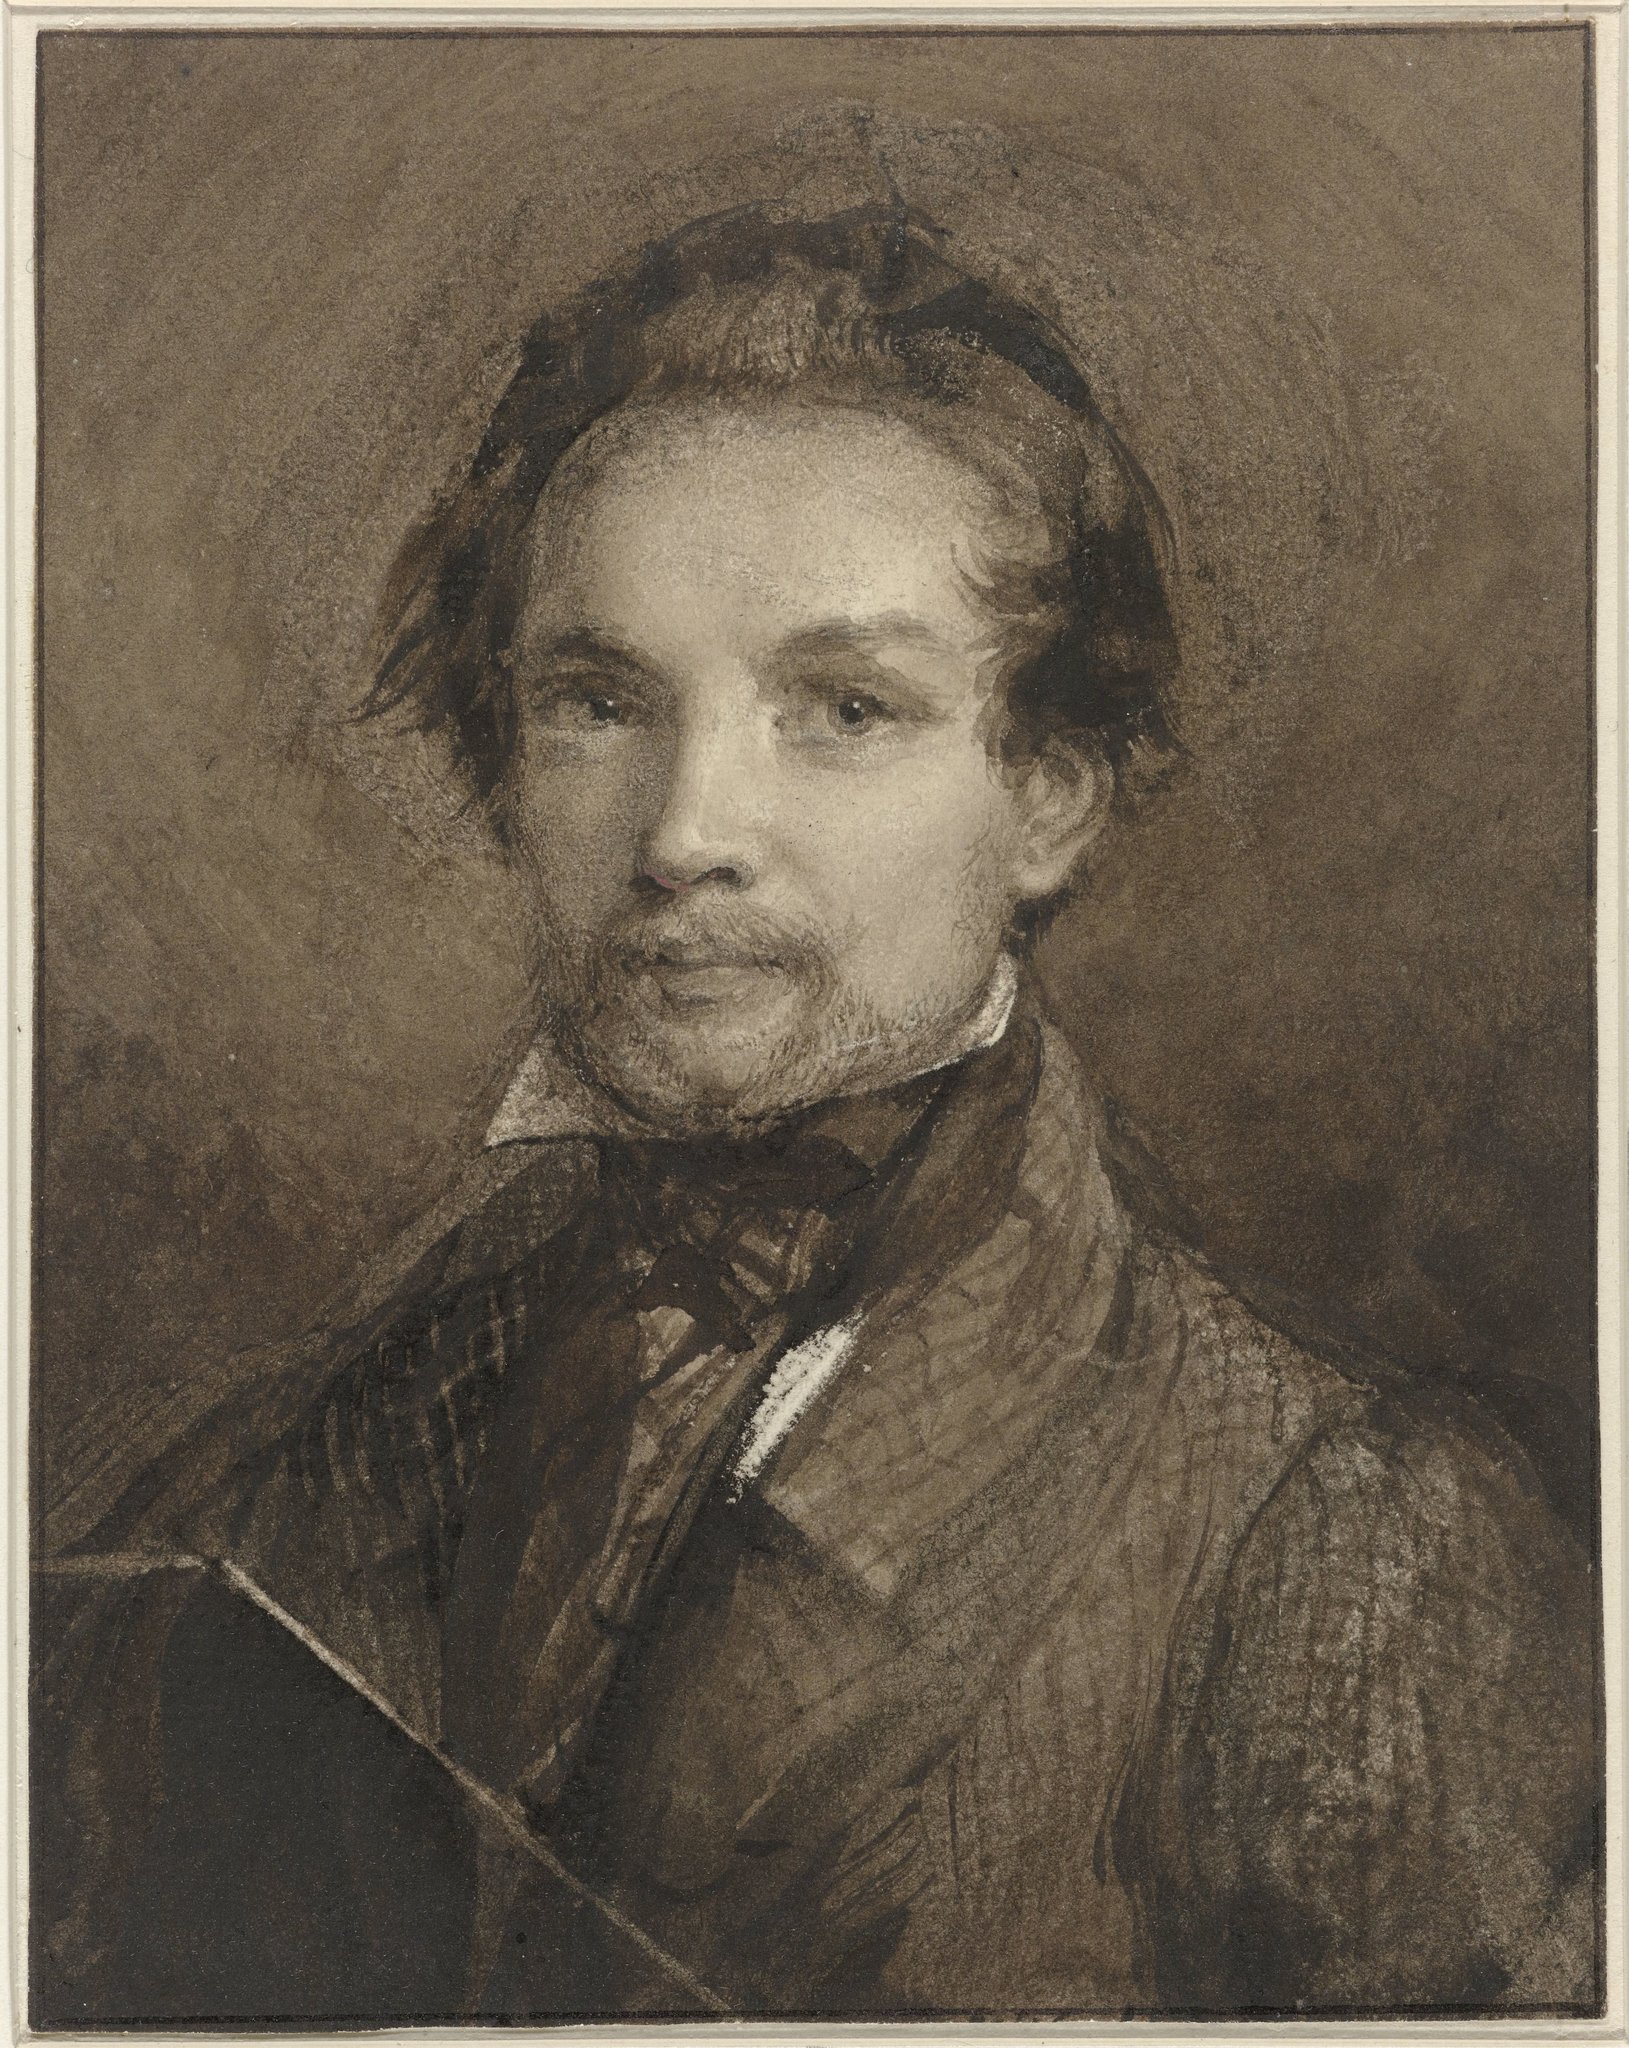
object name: drawing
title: Zelfportret van Johannes de Mare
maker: johannes de mare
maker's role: draughtsman, print maker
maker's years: 1806-1889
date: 1816-1889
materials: paper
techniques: brush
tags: amsterdam, print maker, draughtsman, johannes de mare, historical persons, portrait, self-portrait of artist